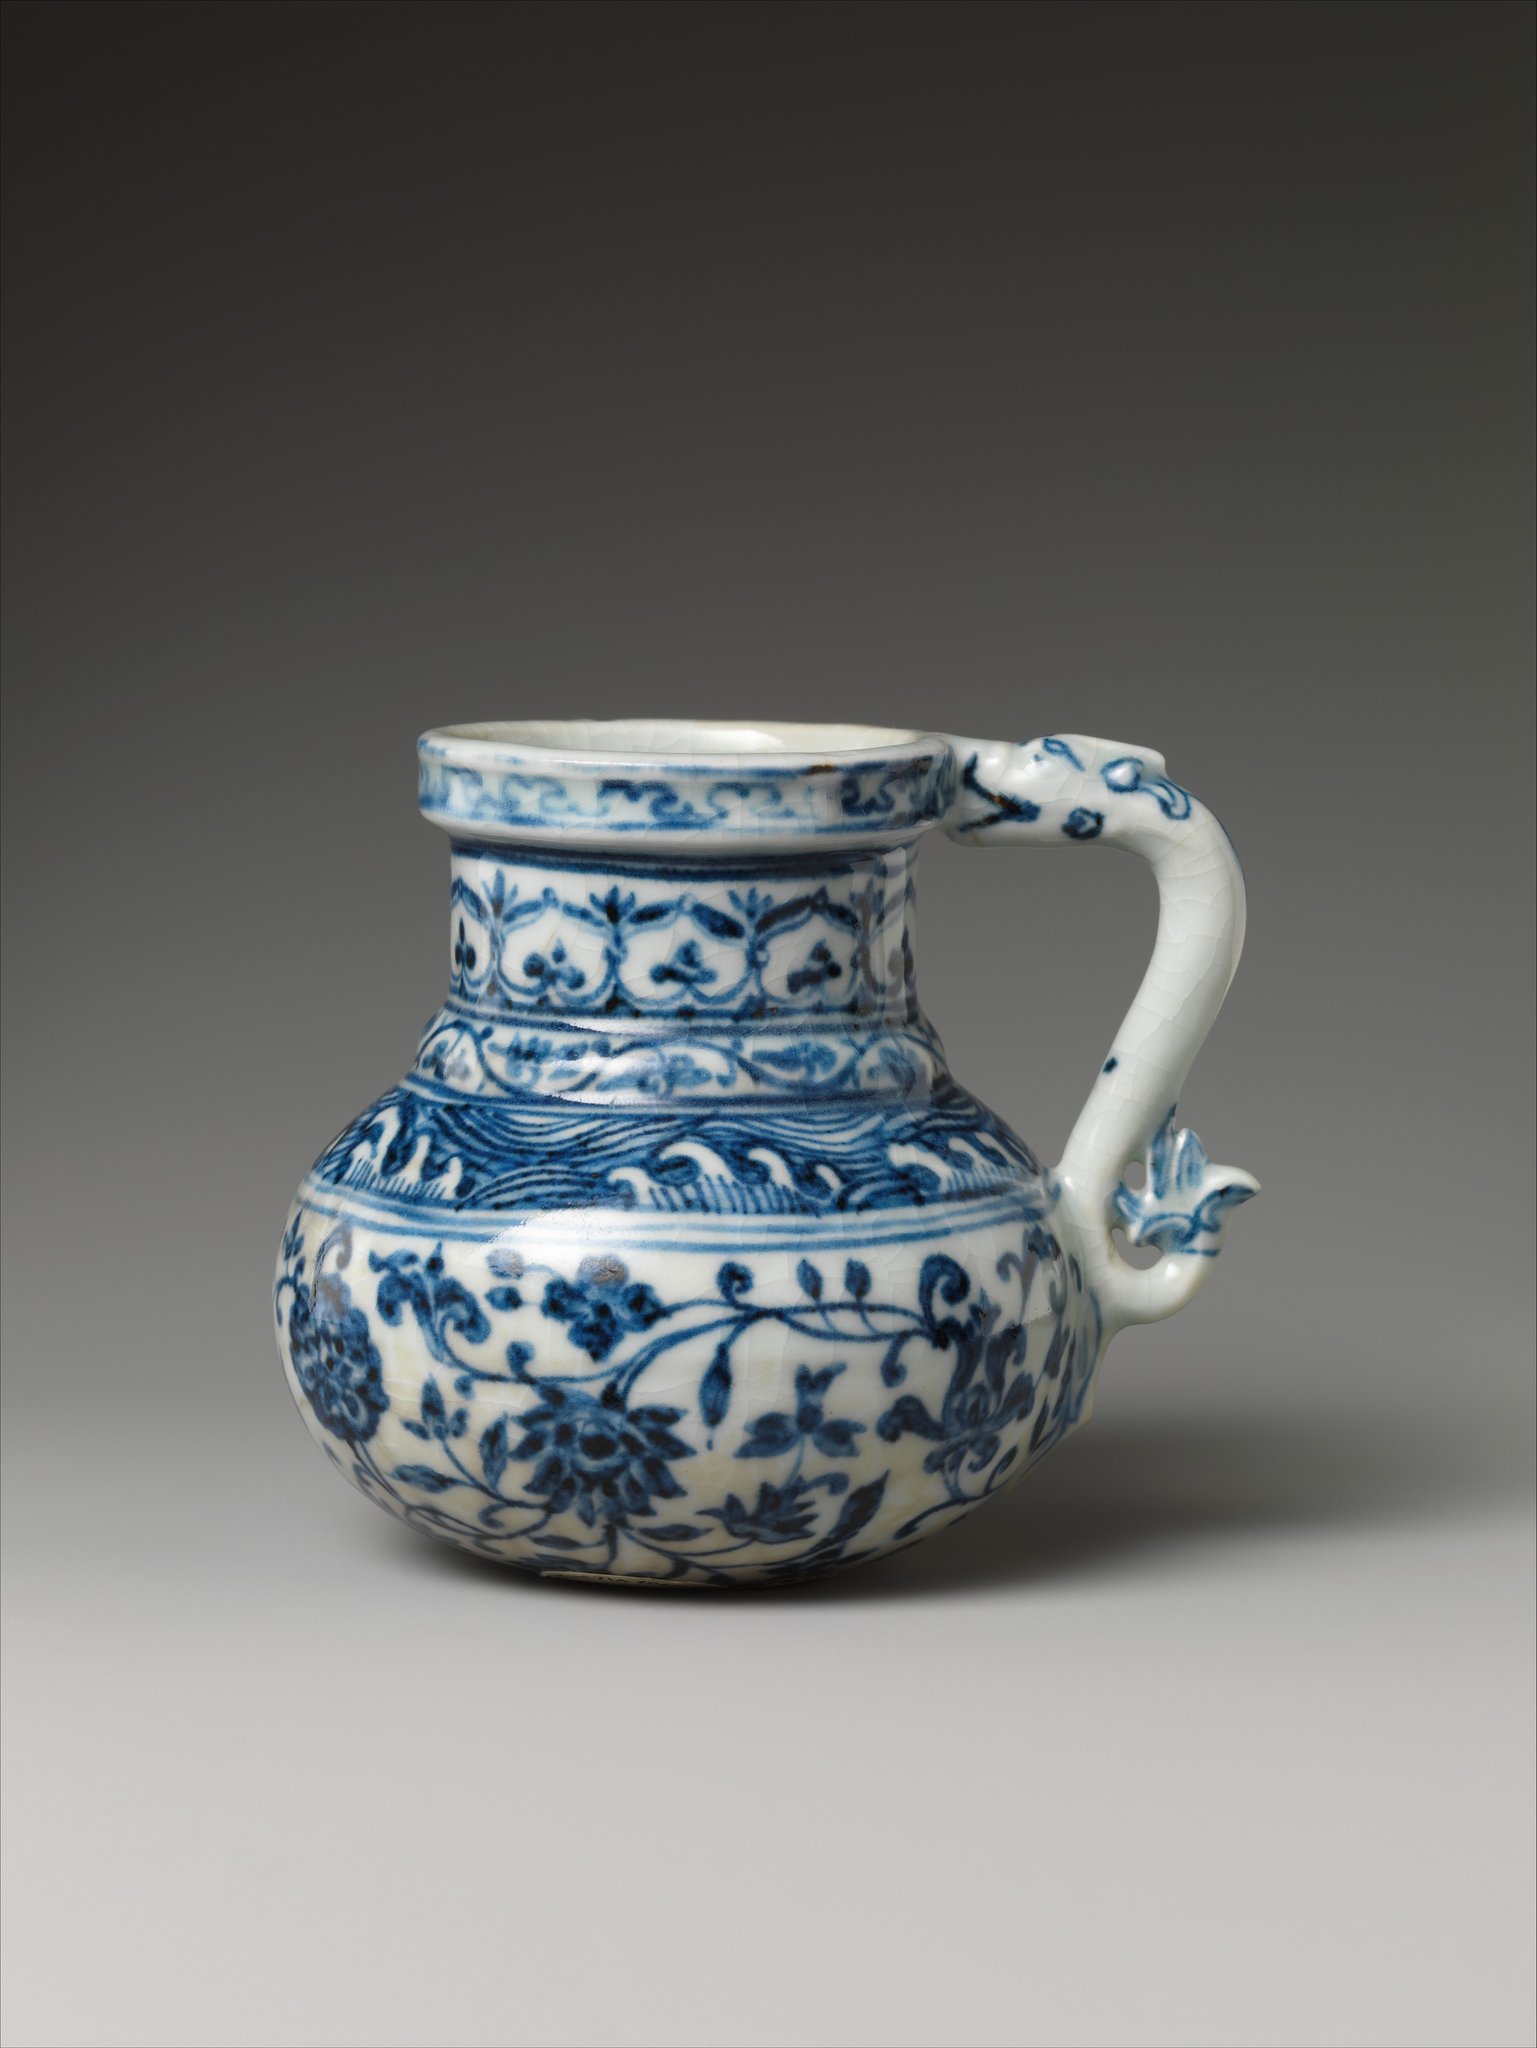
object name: tankard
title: Tankard with Peony Scroll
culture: chinese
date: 1401-1433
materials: cobalt, glaze, porcelain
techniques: painting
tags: peonies